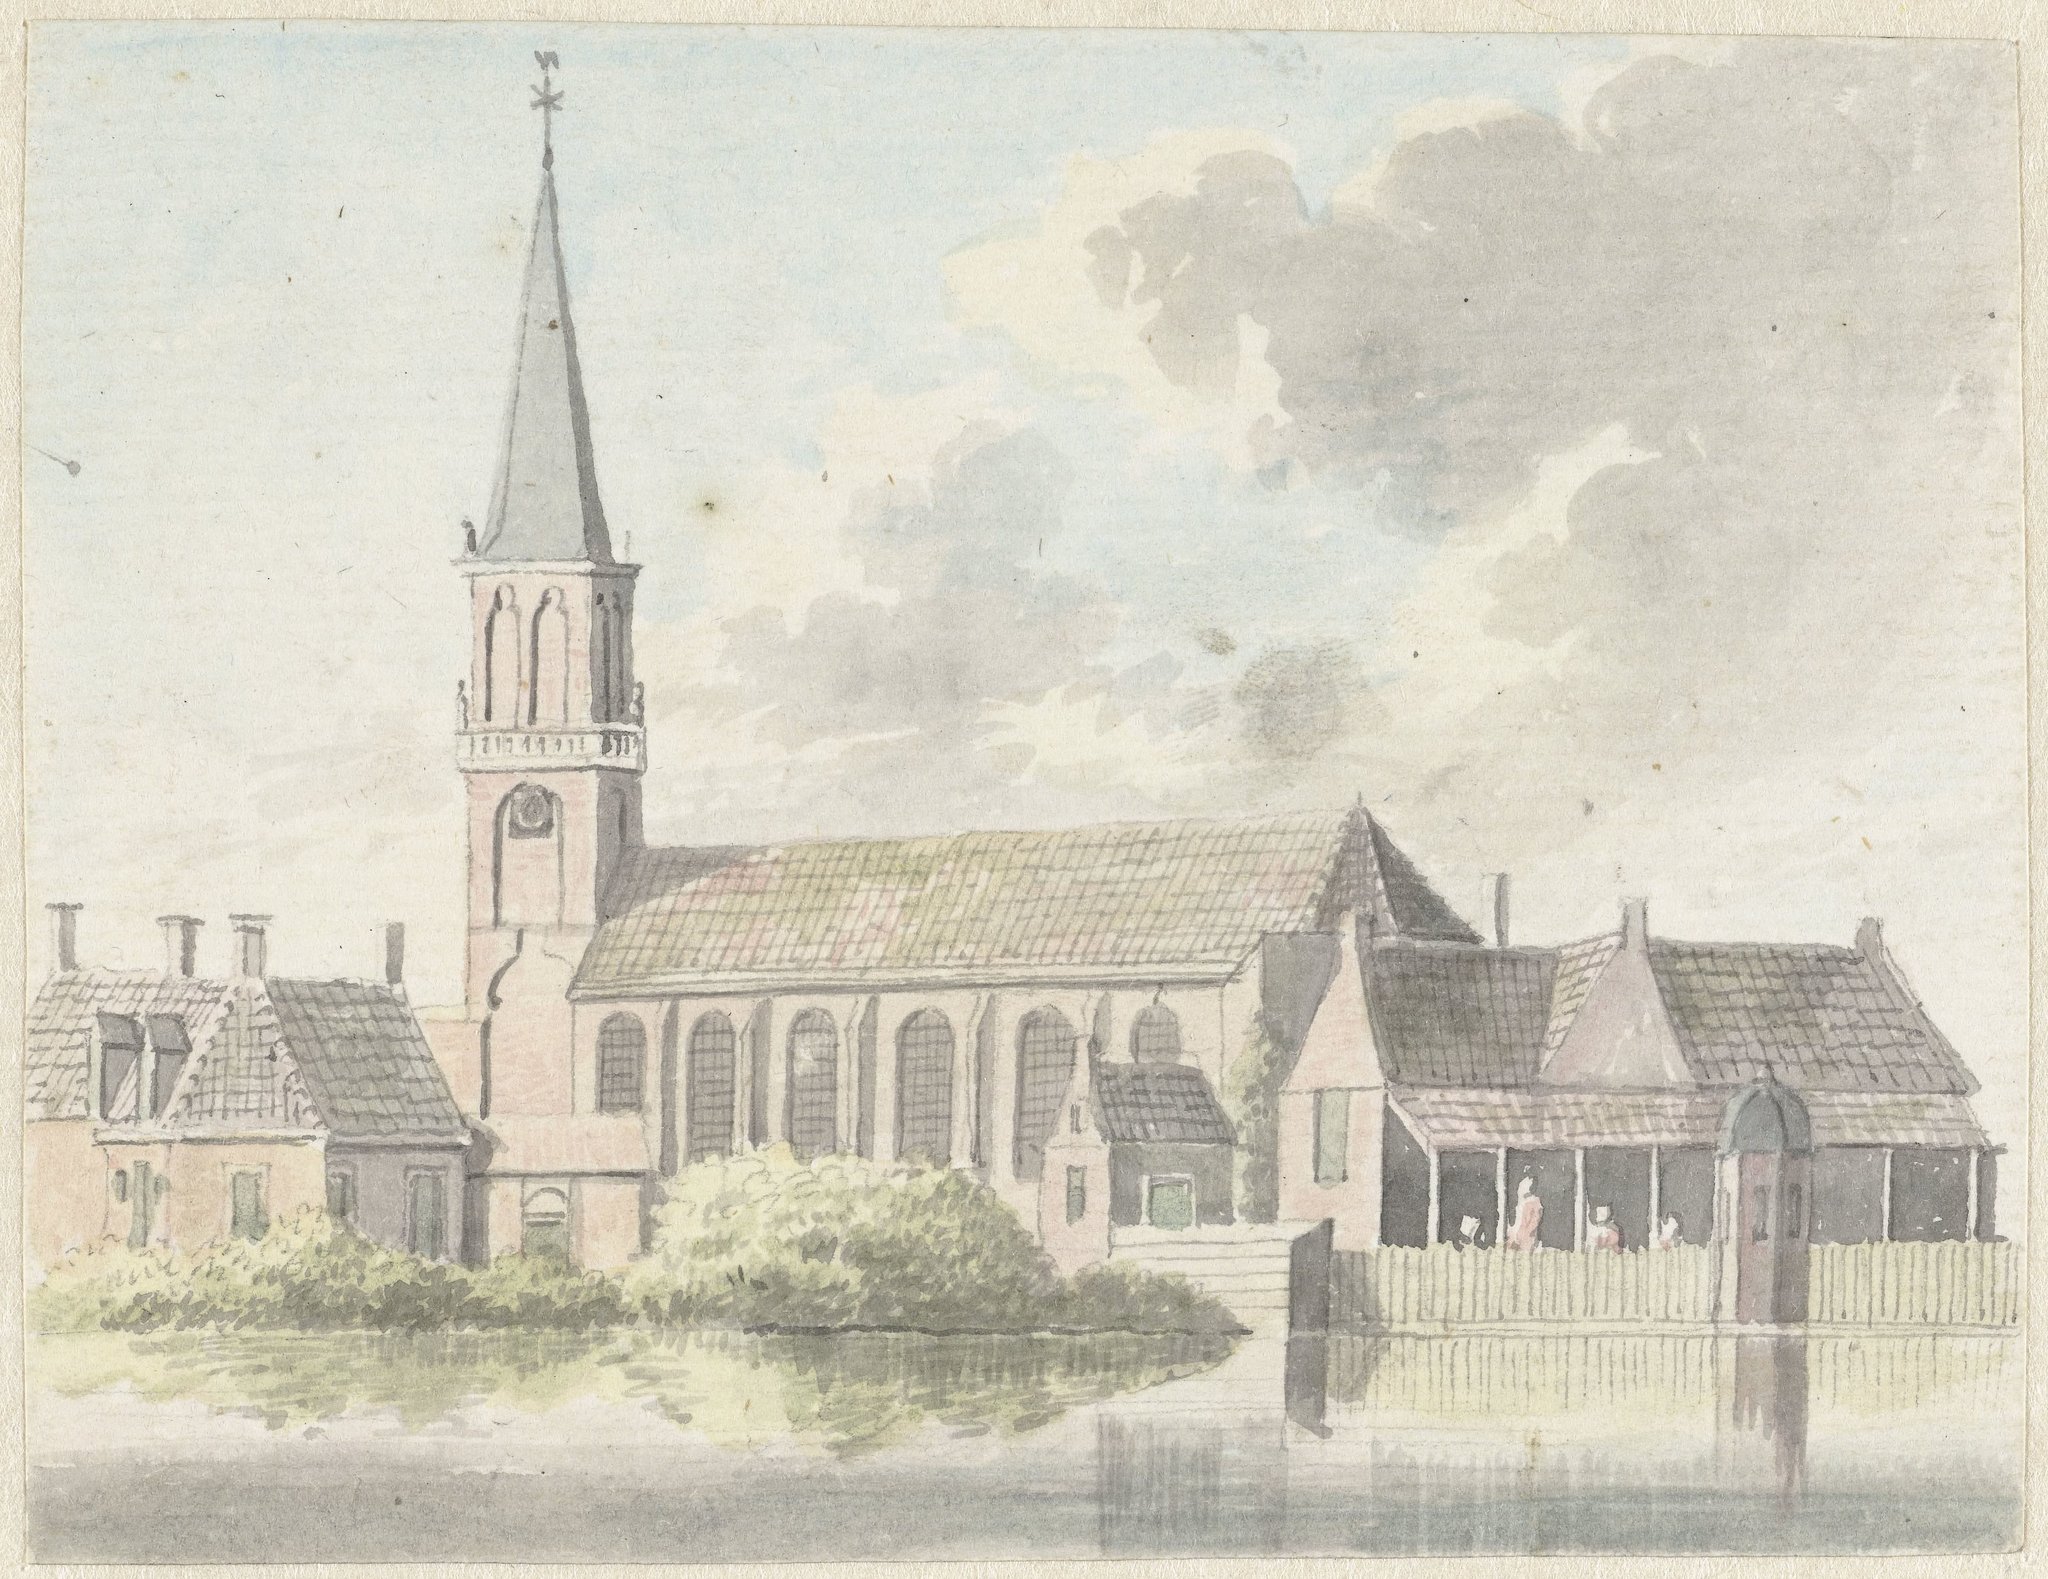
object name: drawing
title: Kerk te Broek in Waterland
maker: hendrik tavenier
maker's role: draughtsman, print maker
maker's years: 1734-1807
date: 1789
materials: ink, paper, watercolor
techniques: brush, pen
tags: church (exterior)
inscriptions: inscription: ‘Broek in Waaterland 1789 / H. Tavener’